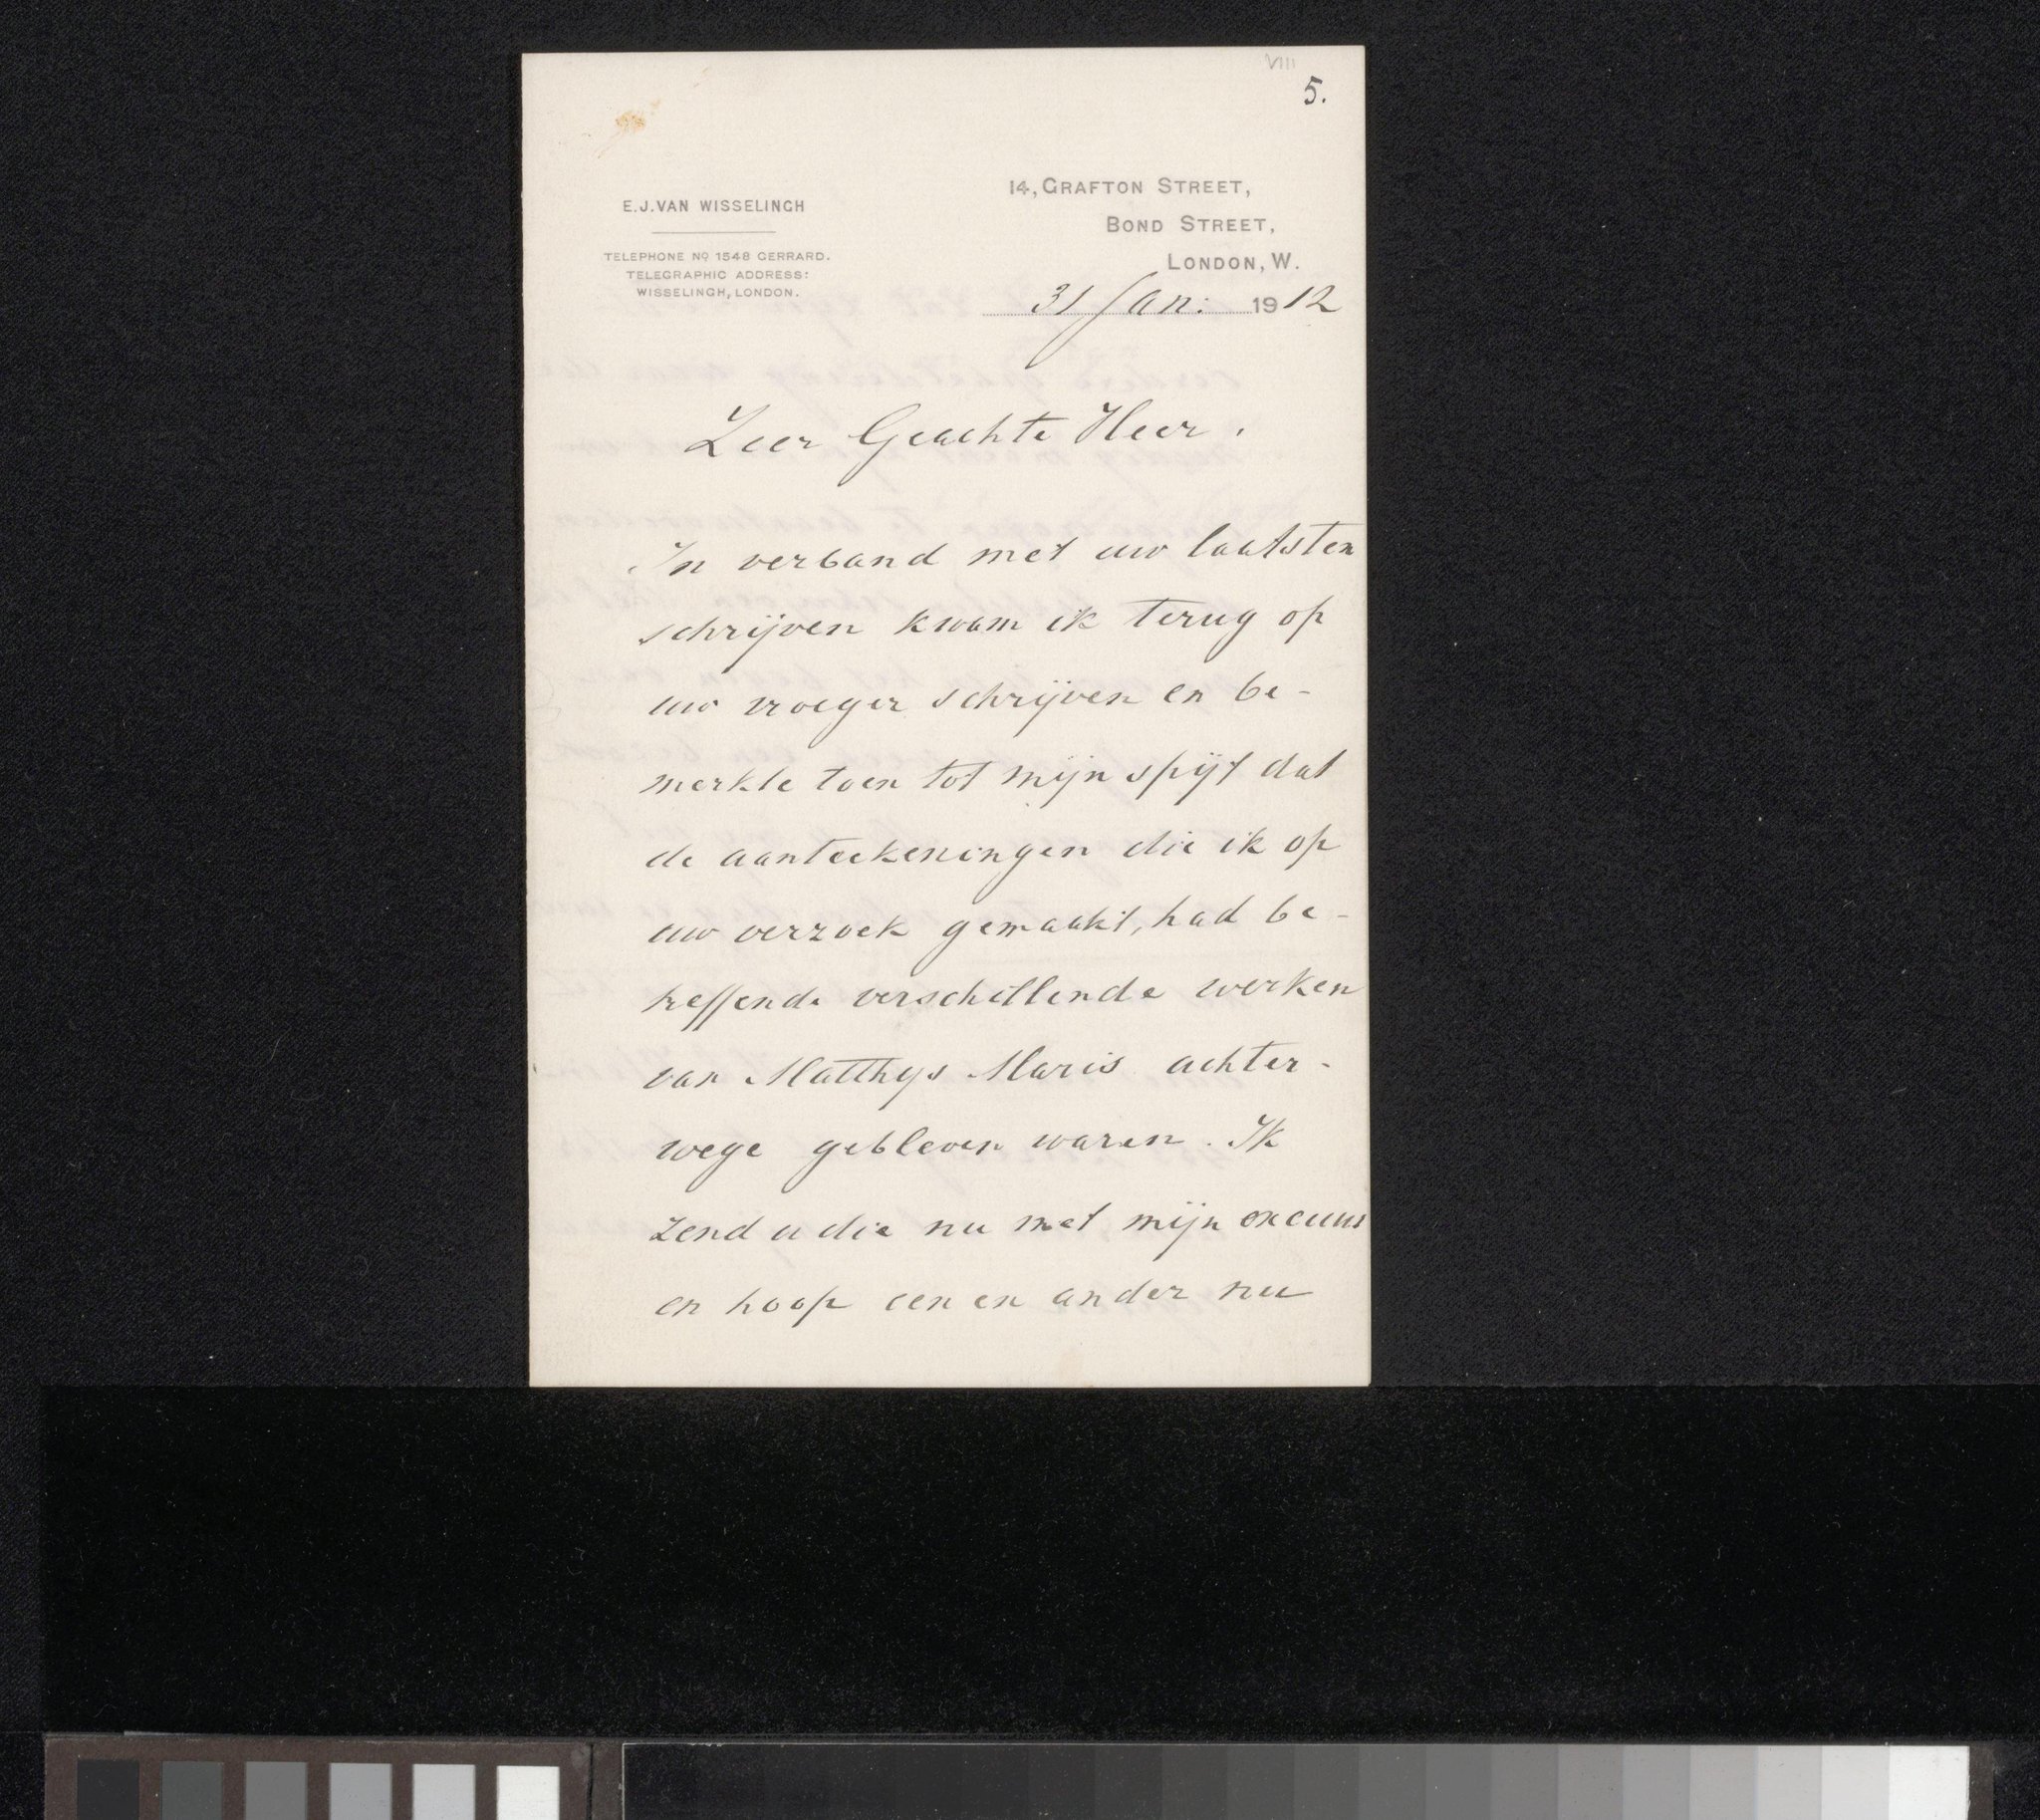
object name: letter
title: Brief aan Pieter Haverkorn van Rijsewijk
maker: elbert jan van wisselingh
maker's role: kunsthandelaar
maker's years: 1848-1912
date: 1912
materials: ink, paper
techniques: pen, printing, writing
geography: london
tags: glasgow, daniel cottier, the hague, london, painter, print maker, draughtsman, matthijs maris, pieter haverkorn van rijsewijk, printer, publisher, art trade, art shop, painting (including book-illumination, miniature-painting), paris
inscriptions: watermark